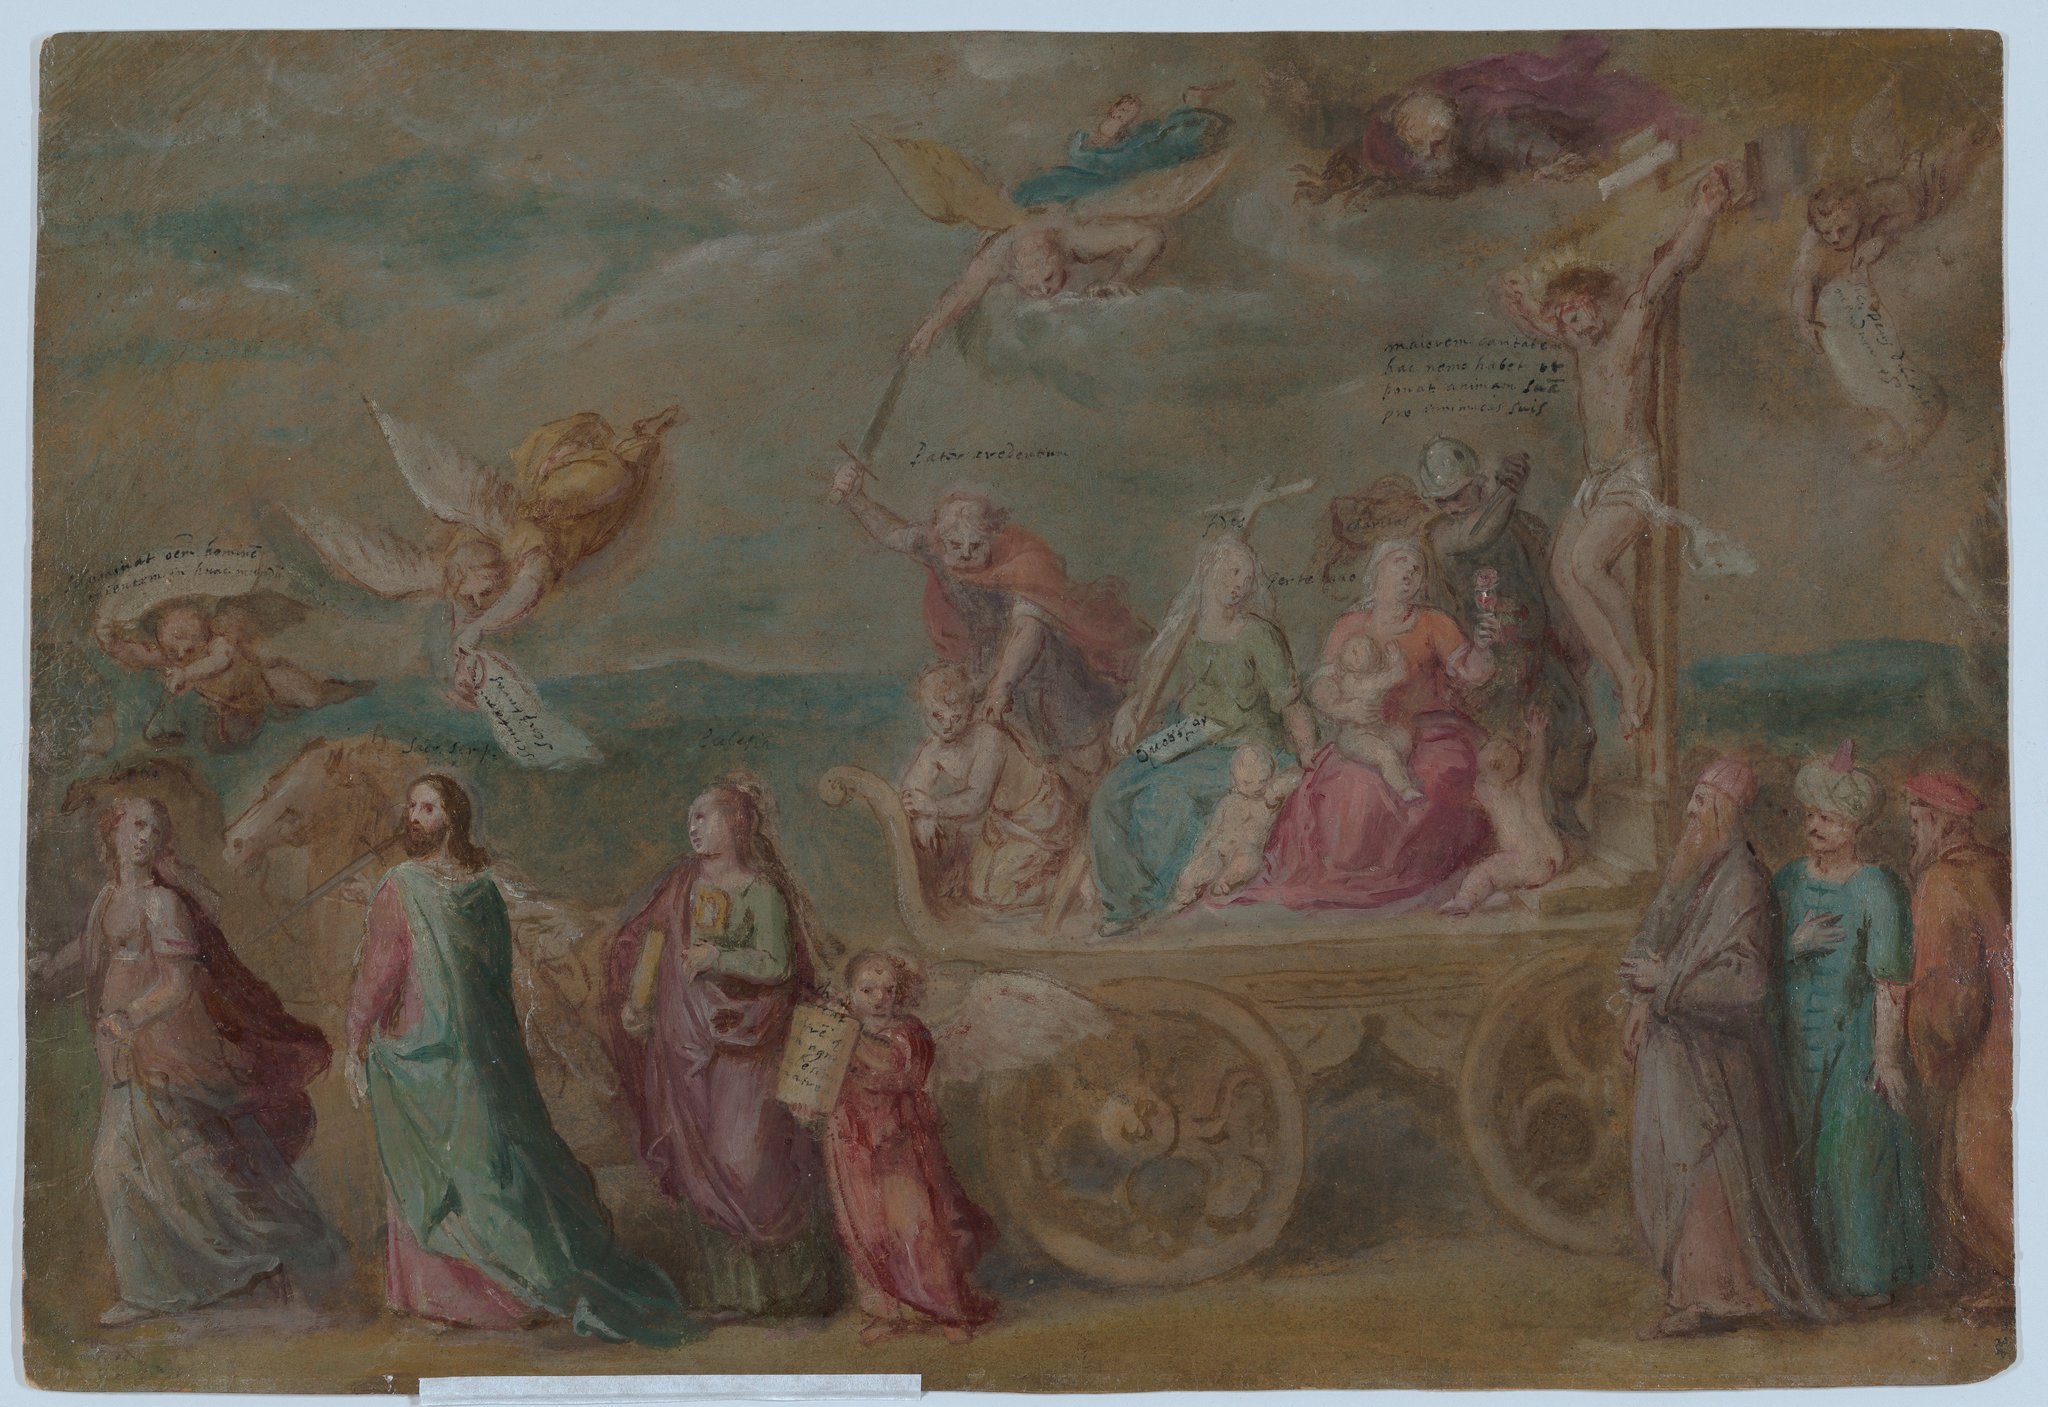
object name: drawing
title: The Triumph of the Word of God, from "Triumph of the Catholic Church" (oil sketch for a painting of the same subject)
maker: otto van veen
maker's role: artist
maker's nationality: netherlandish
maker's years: 1556-1629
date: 1615-1620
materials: ink, oil, paper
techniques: pen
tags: women,angels,christ,crucifixion,chariots